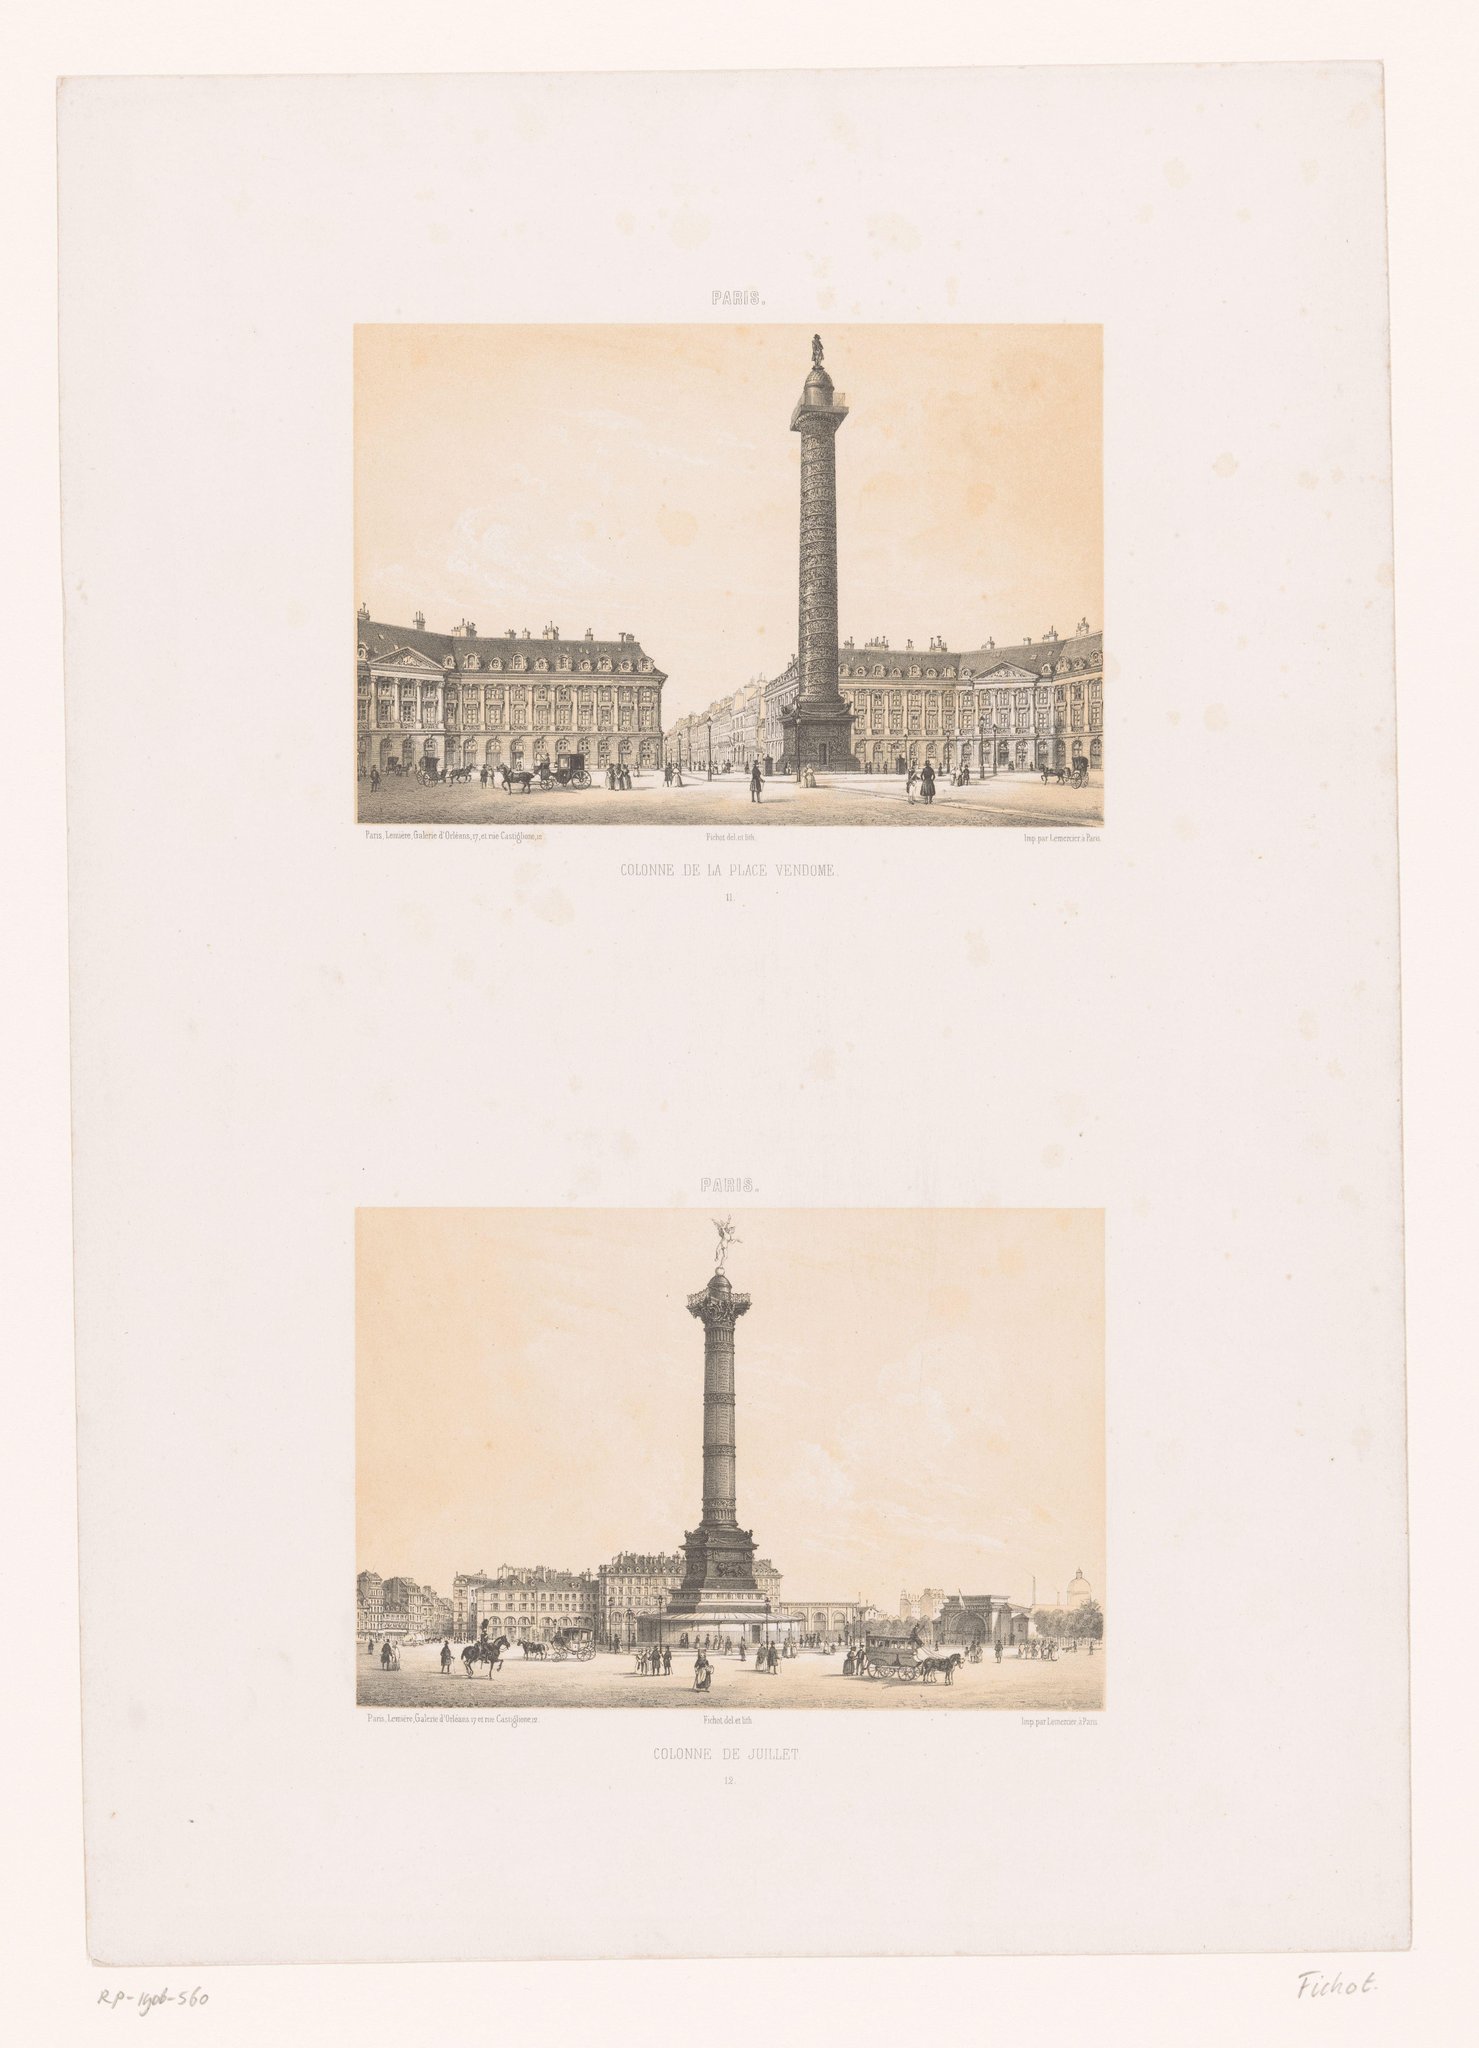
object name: print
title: Zicht op de Colonne Vendôme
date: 1860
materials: paper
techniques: tone lithography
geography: paris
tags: triumphal column with helical friezes (+ city(-scape) with figures, staffage), spiral or solomonic column, square, place, circus, etc. (+ city(-scape) with figures, staffage)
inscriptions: collector's mark: Lugt 2228a